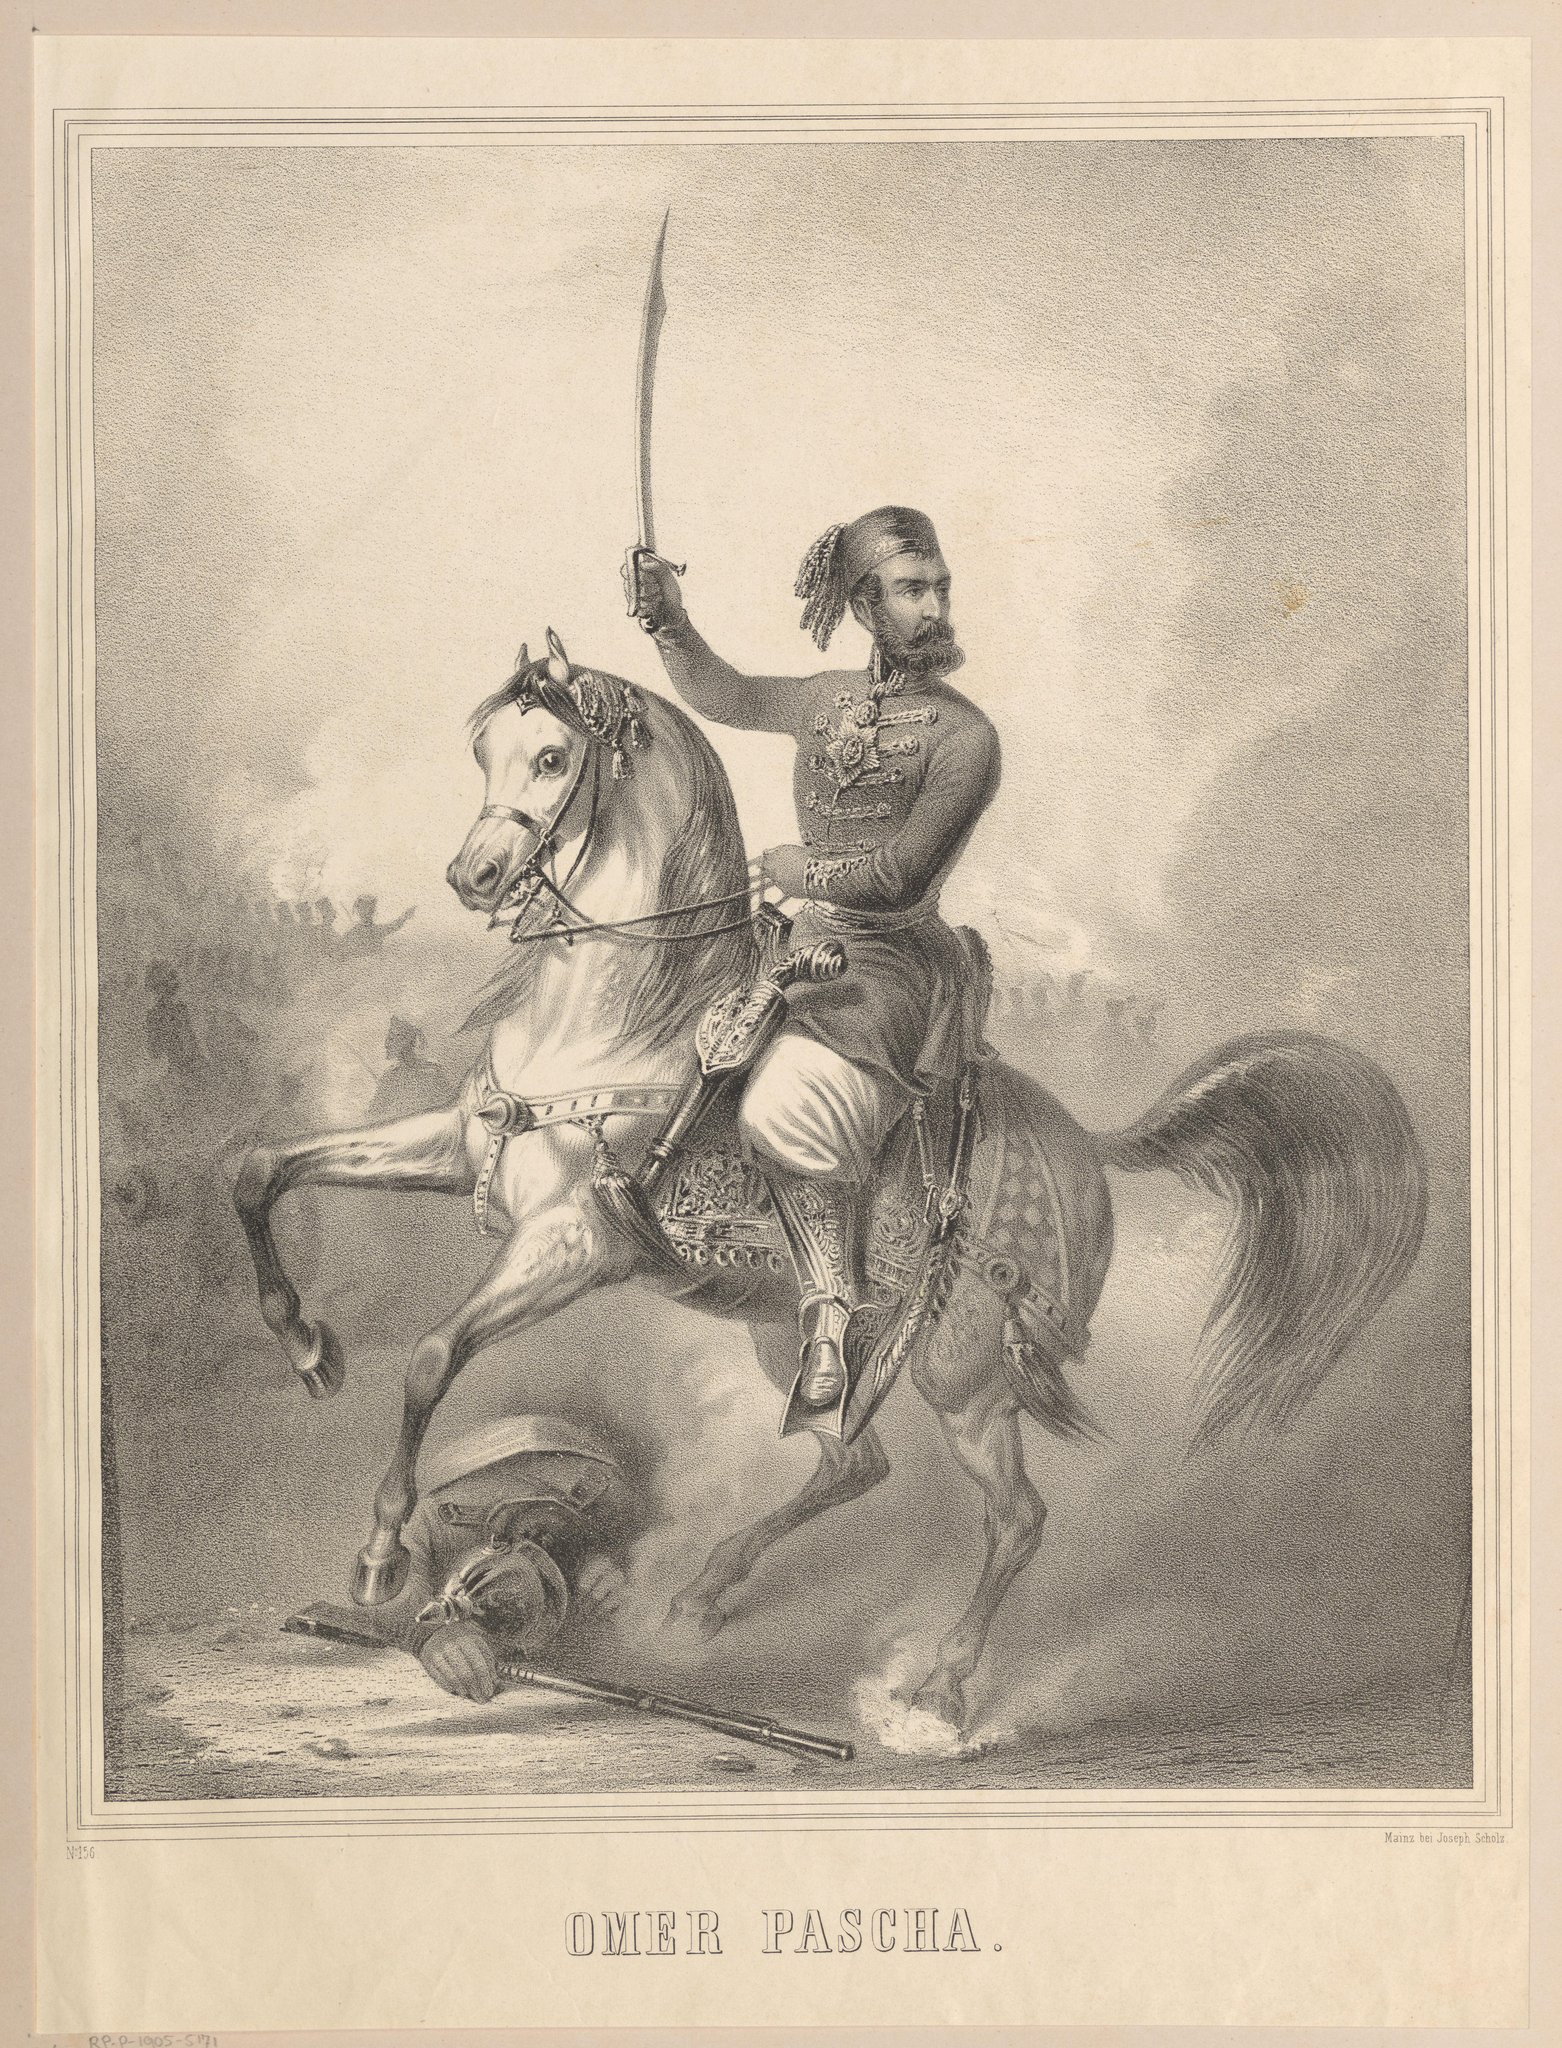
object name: print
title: Portret van Omar Pasha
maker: Anonymous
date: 1823-1880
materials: paper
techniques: lithograph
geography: mainz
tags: historical persons, equestrian statue, hacking and thrusting weapons: sword (+ during the battle)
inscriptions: collector's mark: Lugt 2228